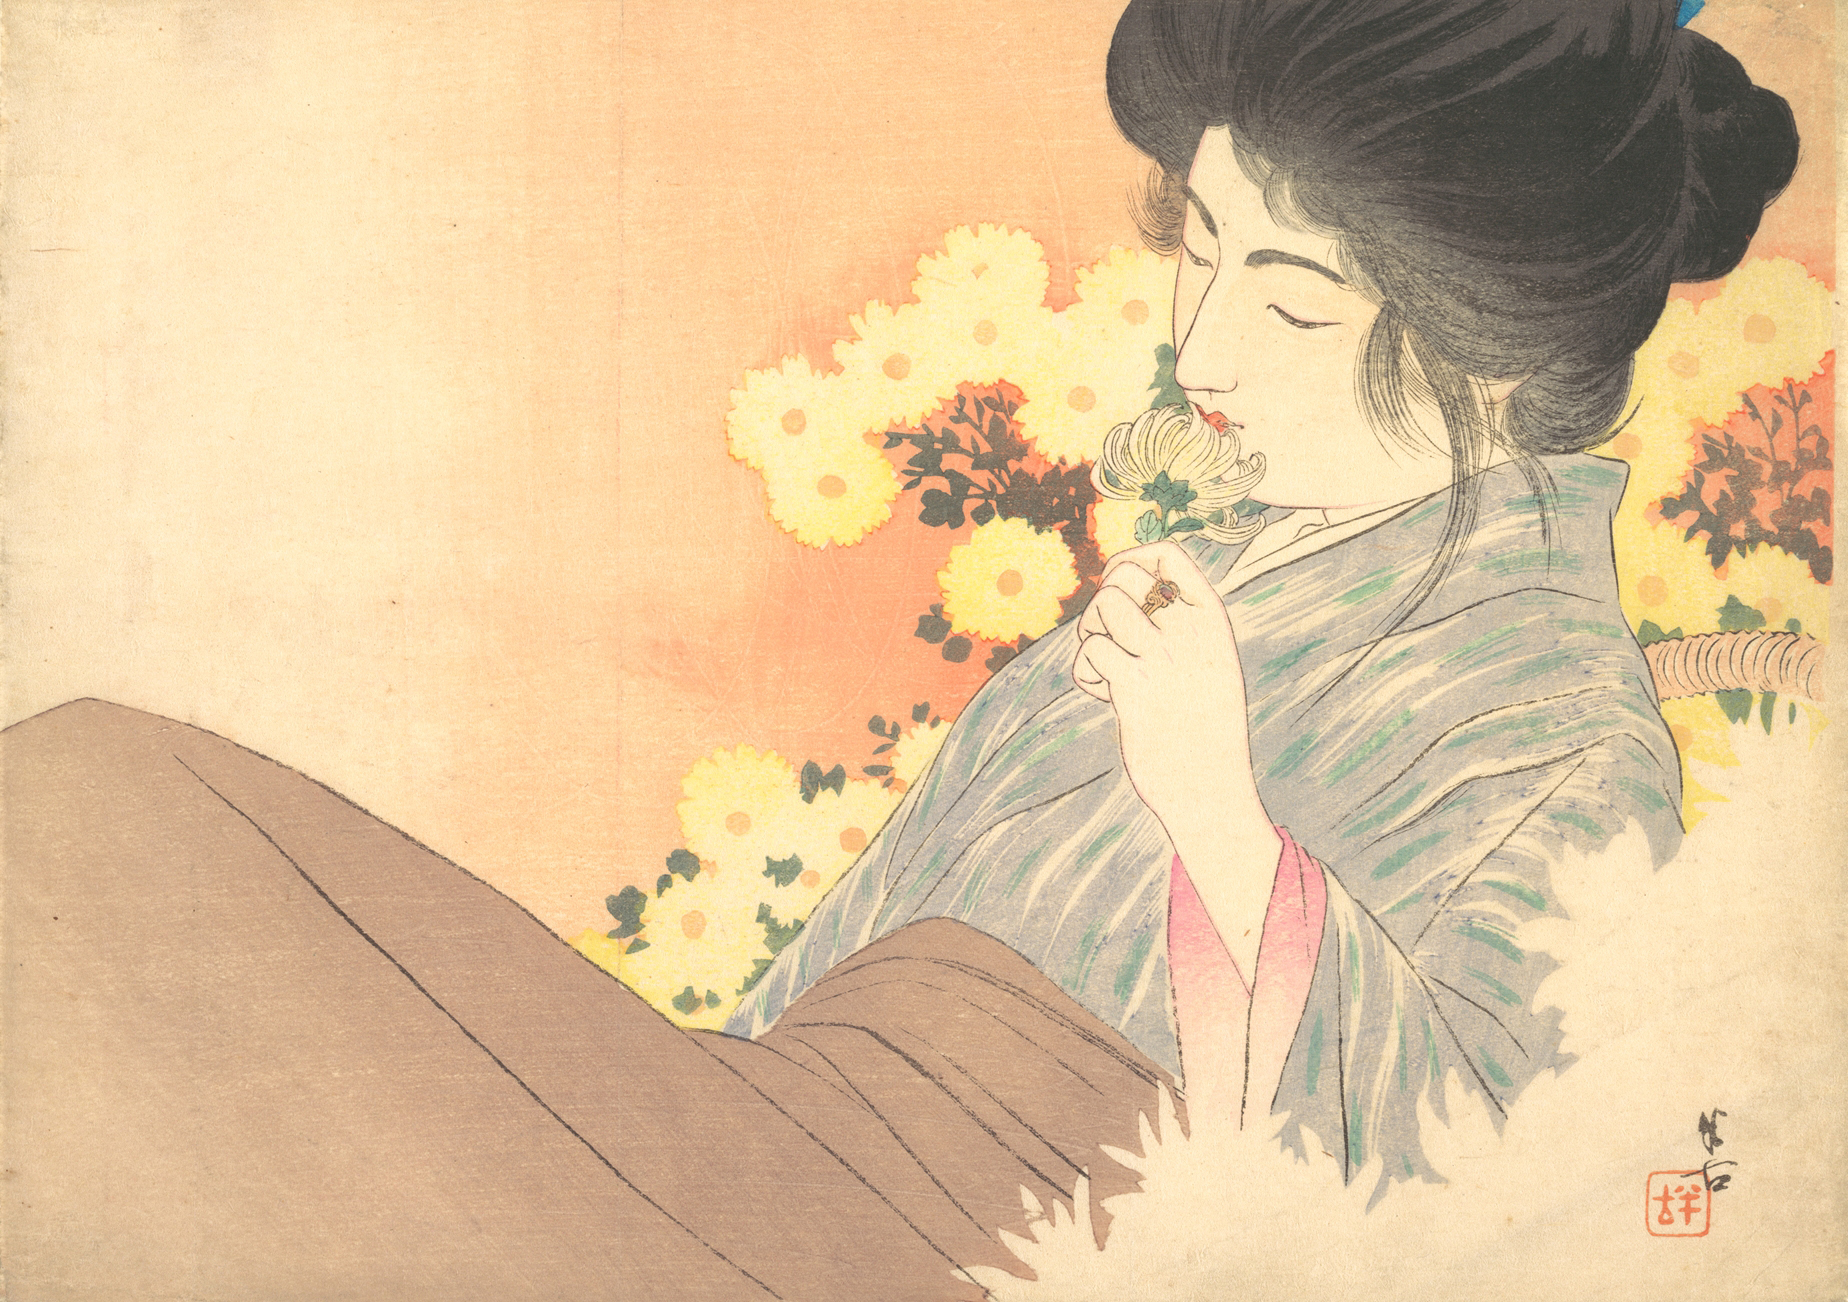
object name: print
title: White Chrysanthemums (kiku no kaori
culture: japanese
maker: kajita hanko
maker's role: artist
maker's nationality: japanese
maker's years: 1870-1917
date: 1902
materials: ink, paper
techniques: woodblock print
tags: women,flowers